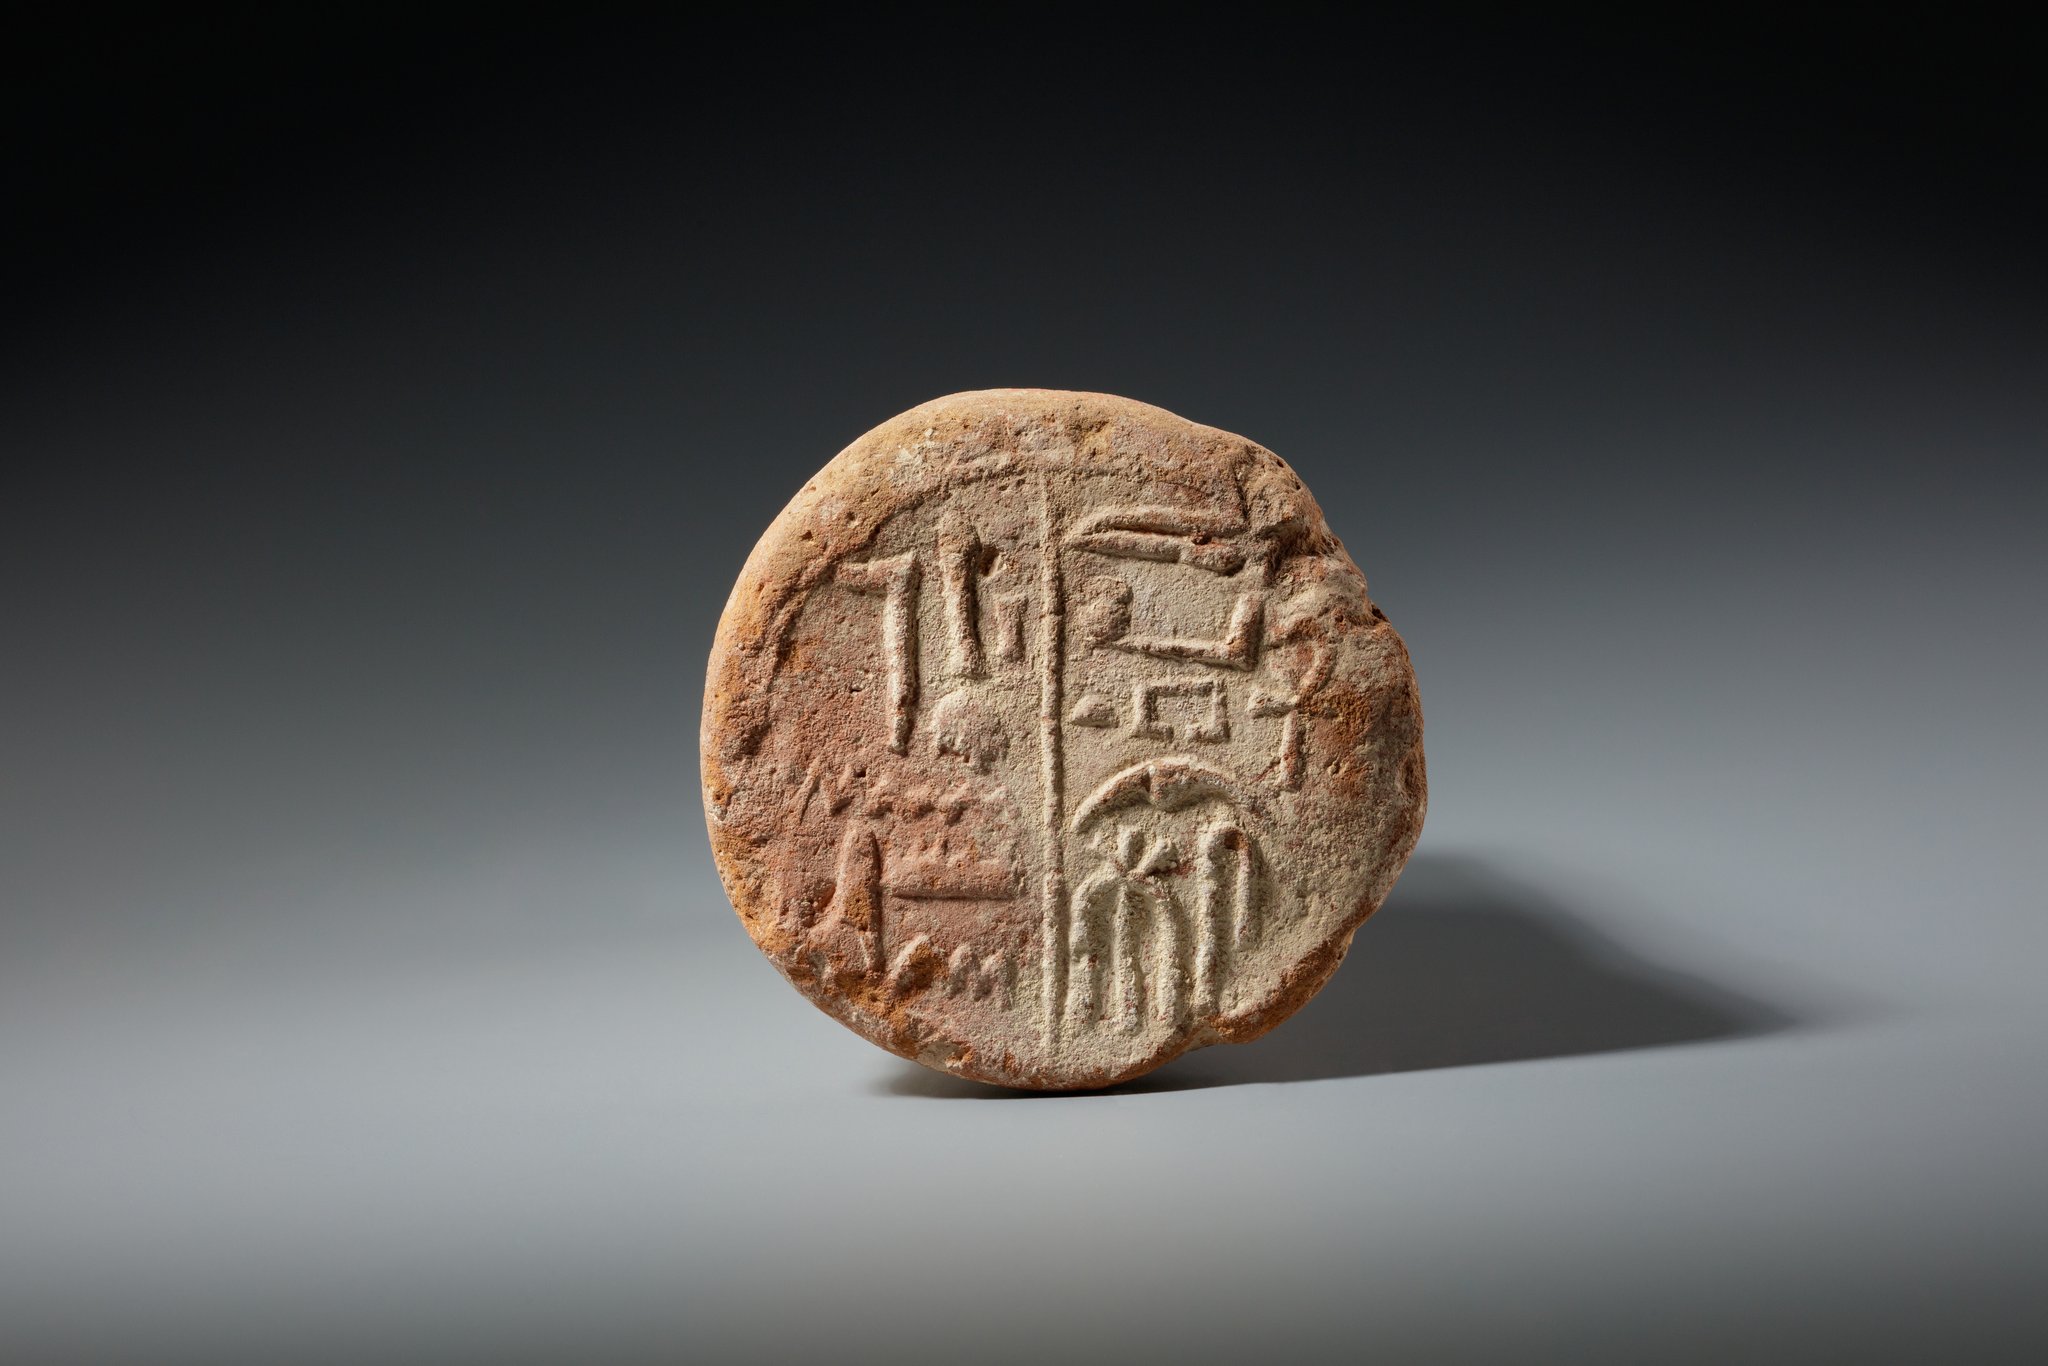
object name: cone, davy 297, ahmose, high priest, amun, thutmose iii, tt 121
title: Funerary Cone of the High Priest Ahmose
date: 1479-1425 BCE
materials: pottery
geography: egypt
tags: hieroglyphs